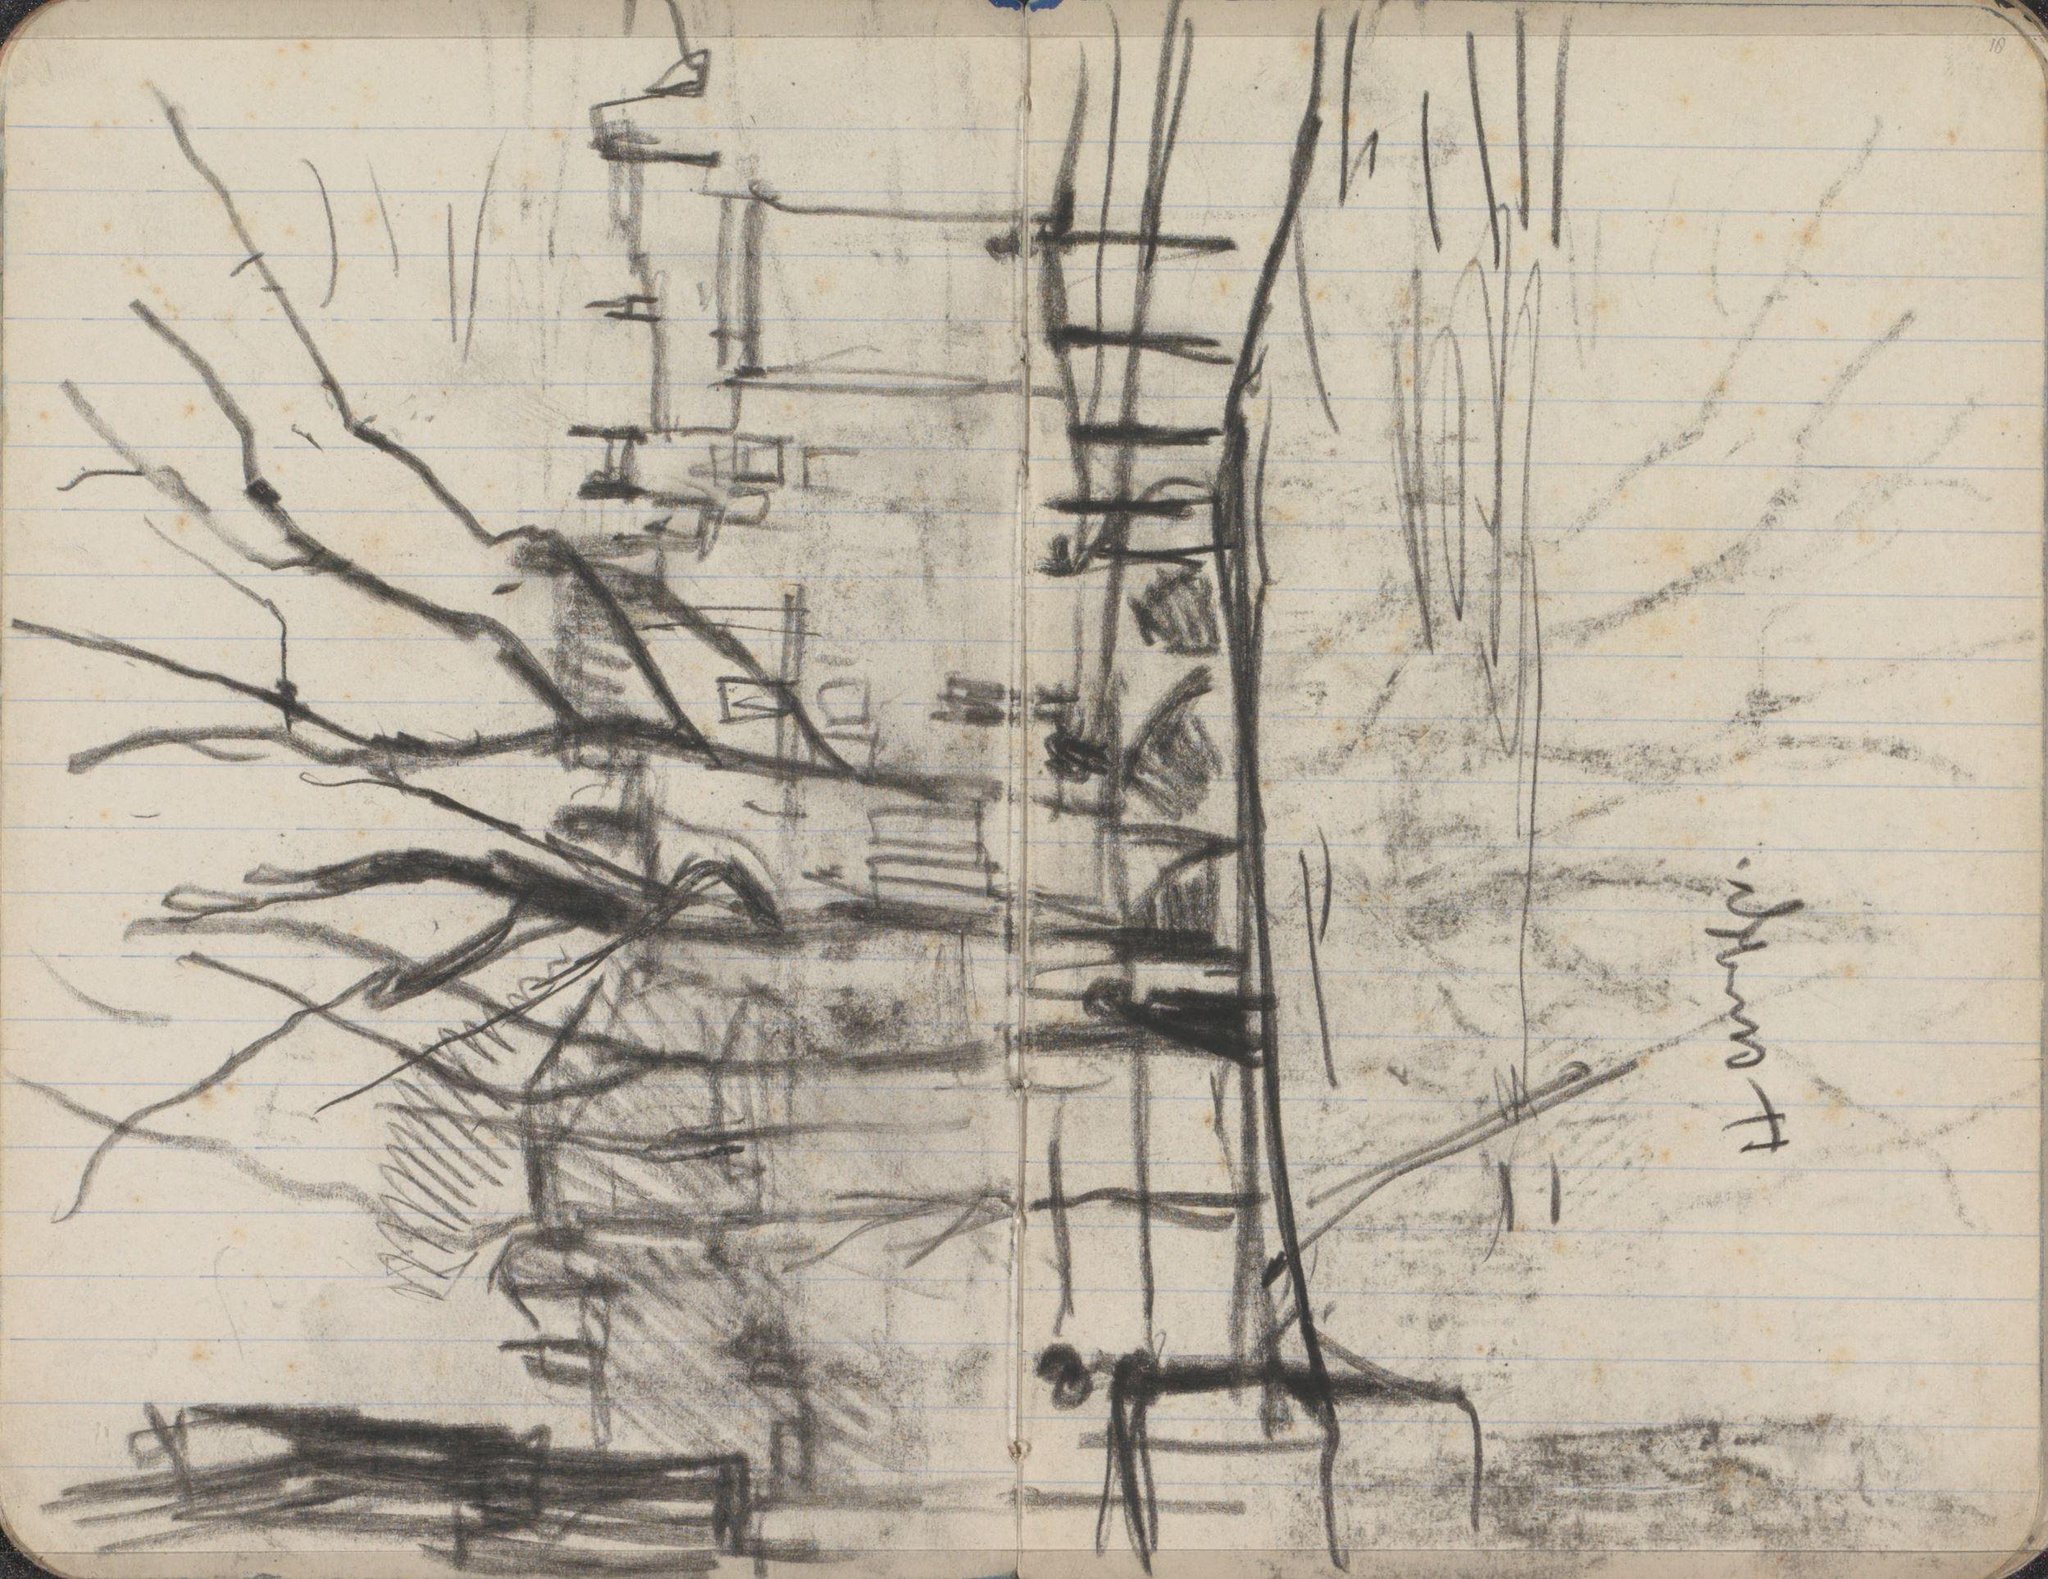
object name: sketchbook leaf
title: Brug over de Herengracht in Amsterdam ter hoogte van de Beulingstraat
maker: george hendrik breitner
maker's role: draughtsman, painter, print maker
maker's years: 1857-1923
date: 1898-1902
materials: chalk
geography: amsterdam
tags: bridge in city across river, canal, etc., civic architecture; edifices; dwellings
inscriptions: annotation: ‘Herengr.’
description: Pagina 17 en pagina 18 uit een schetsboek met 42 bladen.